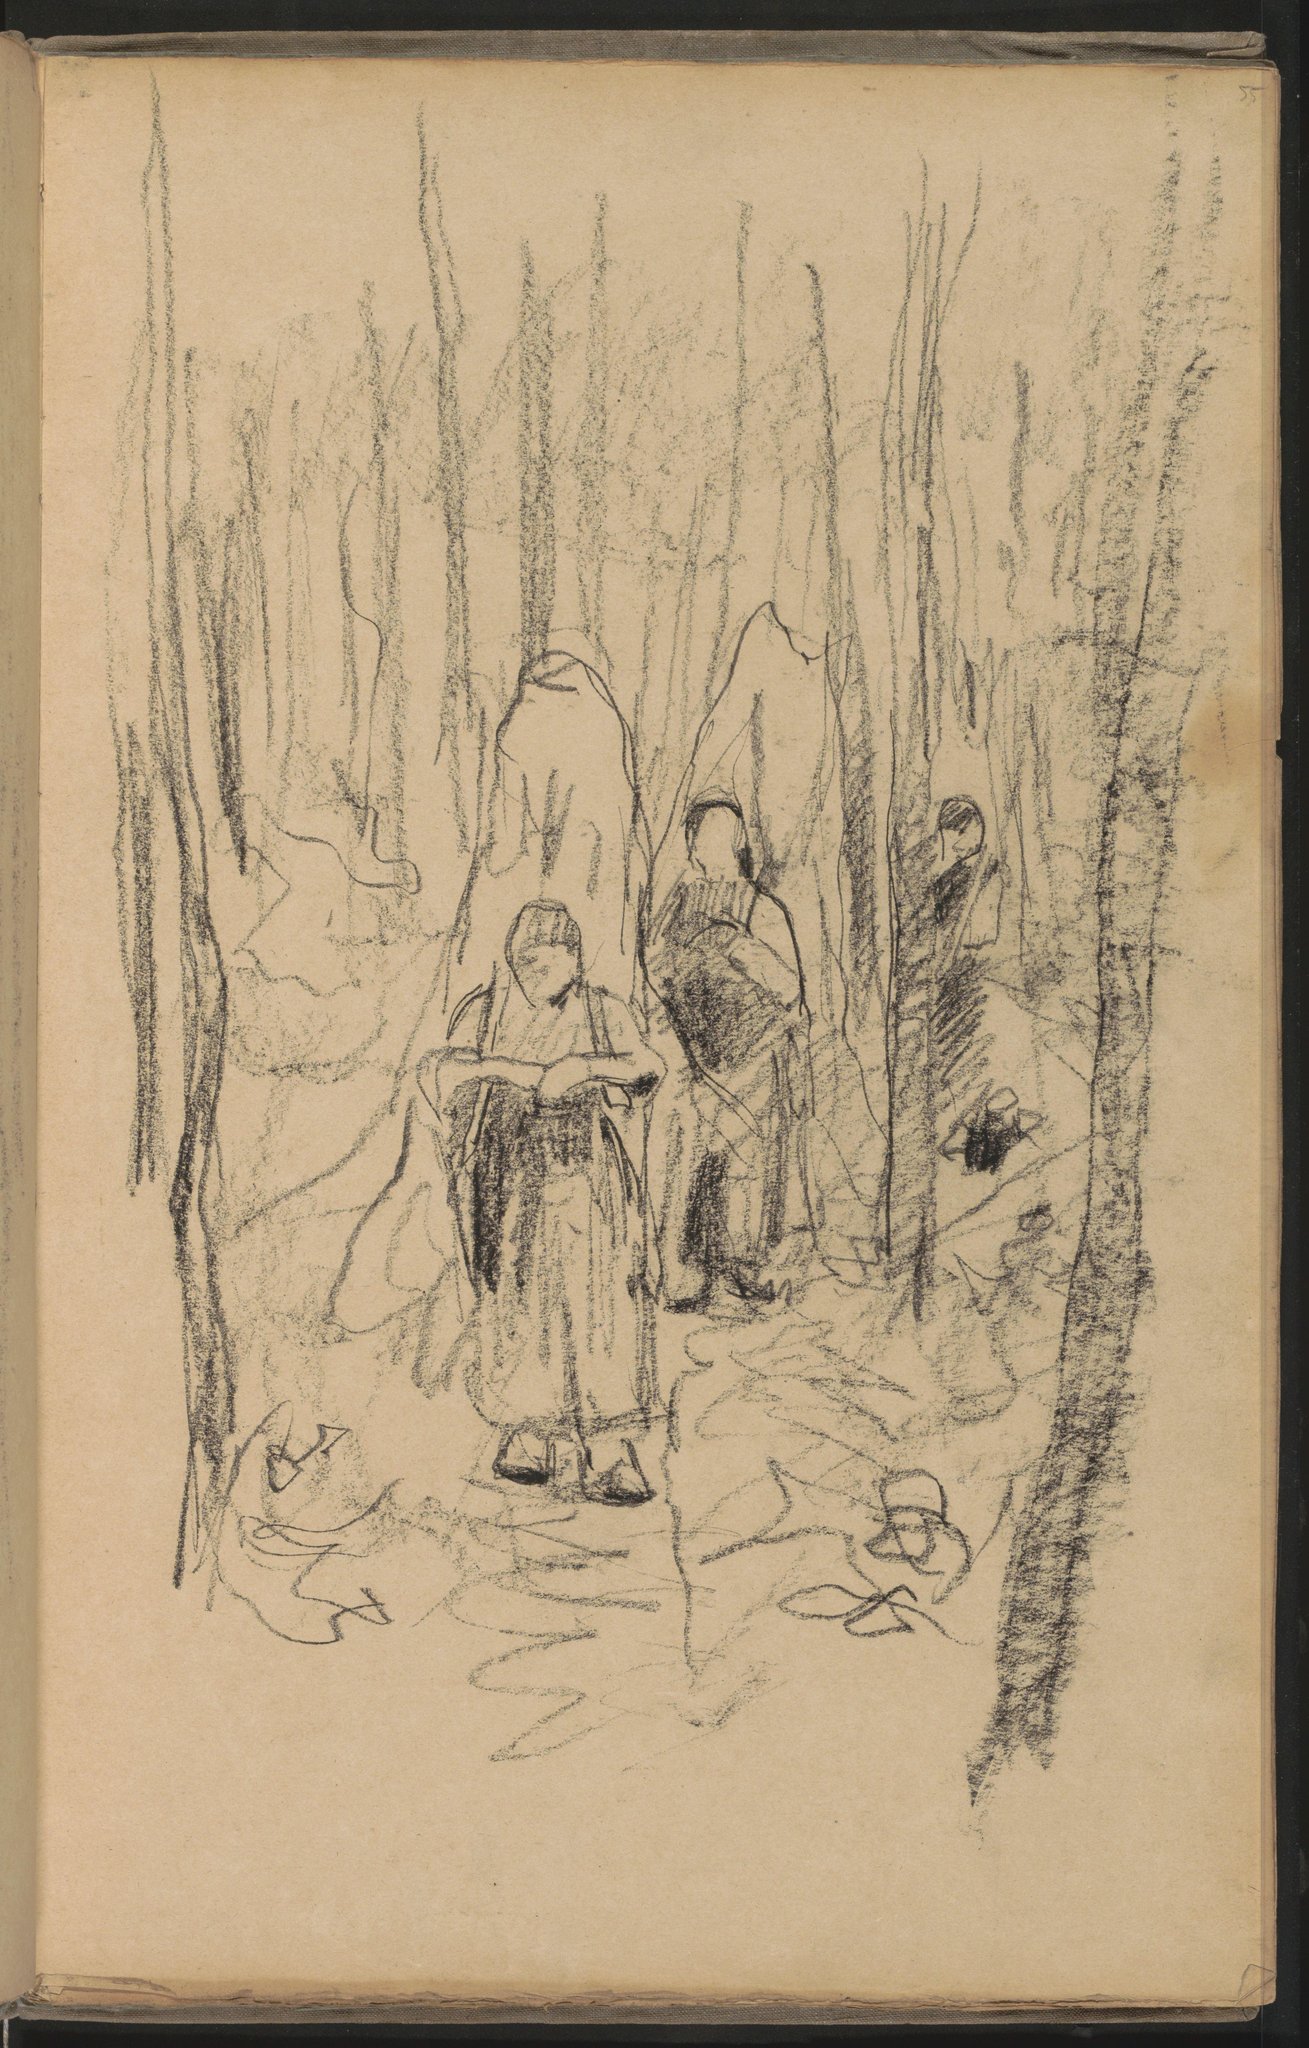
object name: sketchbook leaf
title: Vrouwen met takkenbossen in een bos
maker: willem witsen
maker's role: draughtsman, painter, print maker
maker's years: 1860-1923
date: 1884-1887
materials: chalk, paper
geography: ewijkshoeve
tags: trees (+ bundle of twigs, faggot), adult woman, woodgathering, woodgatherer, forest, wood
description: Houtsprokkelaarsters. Pagina 55 uit een schetsboek met 42 bladen vervaardigd rond de Ewijkshoeve.